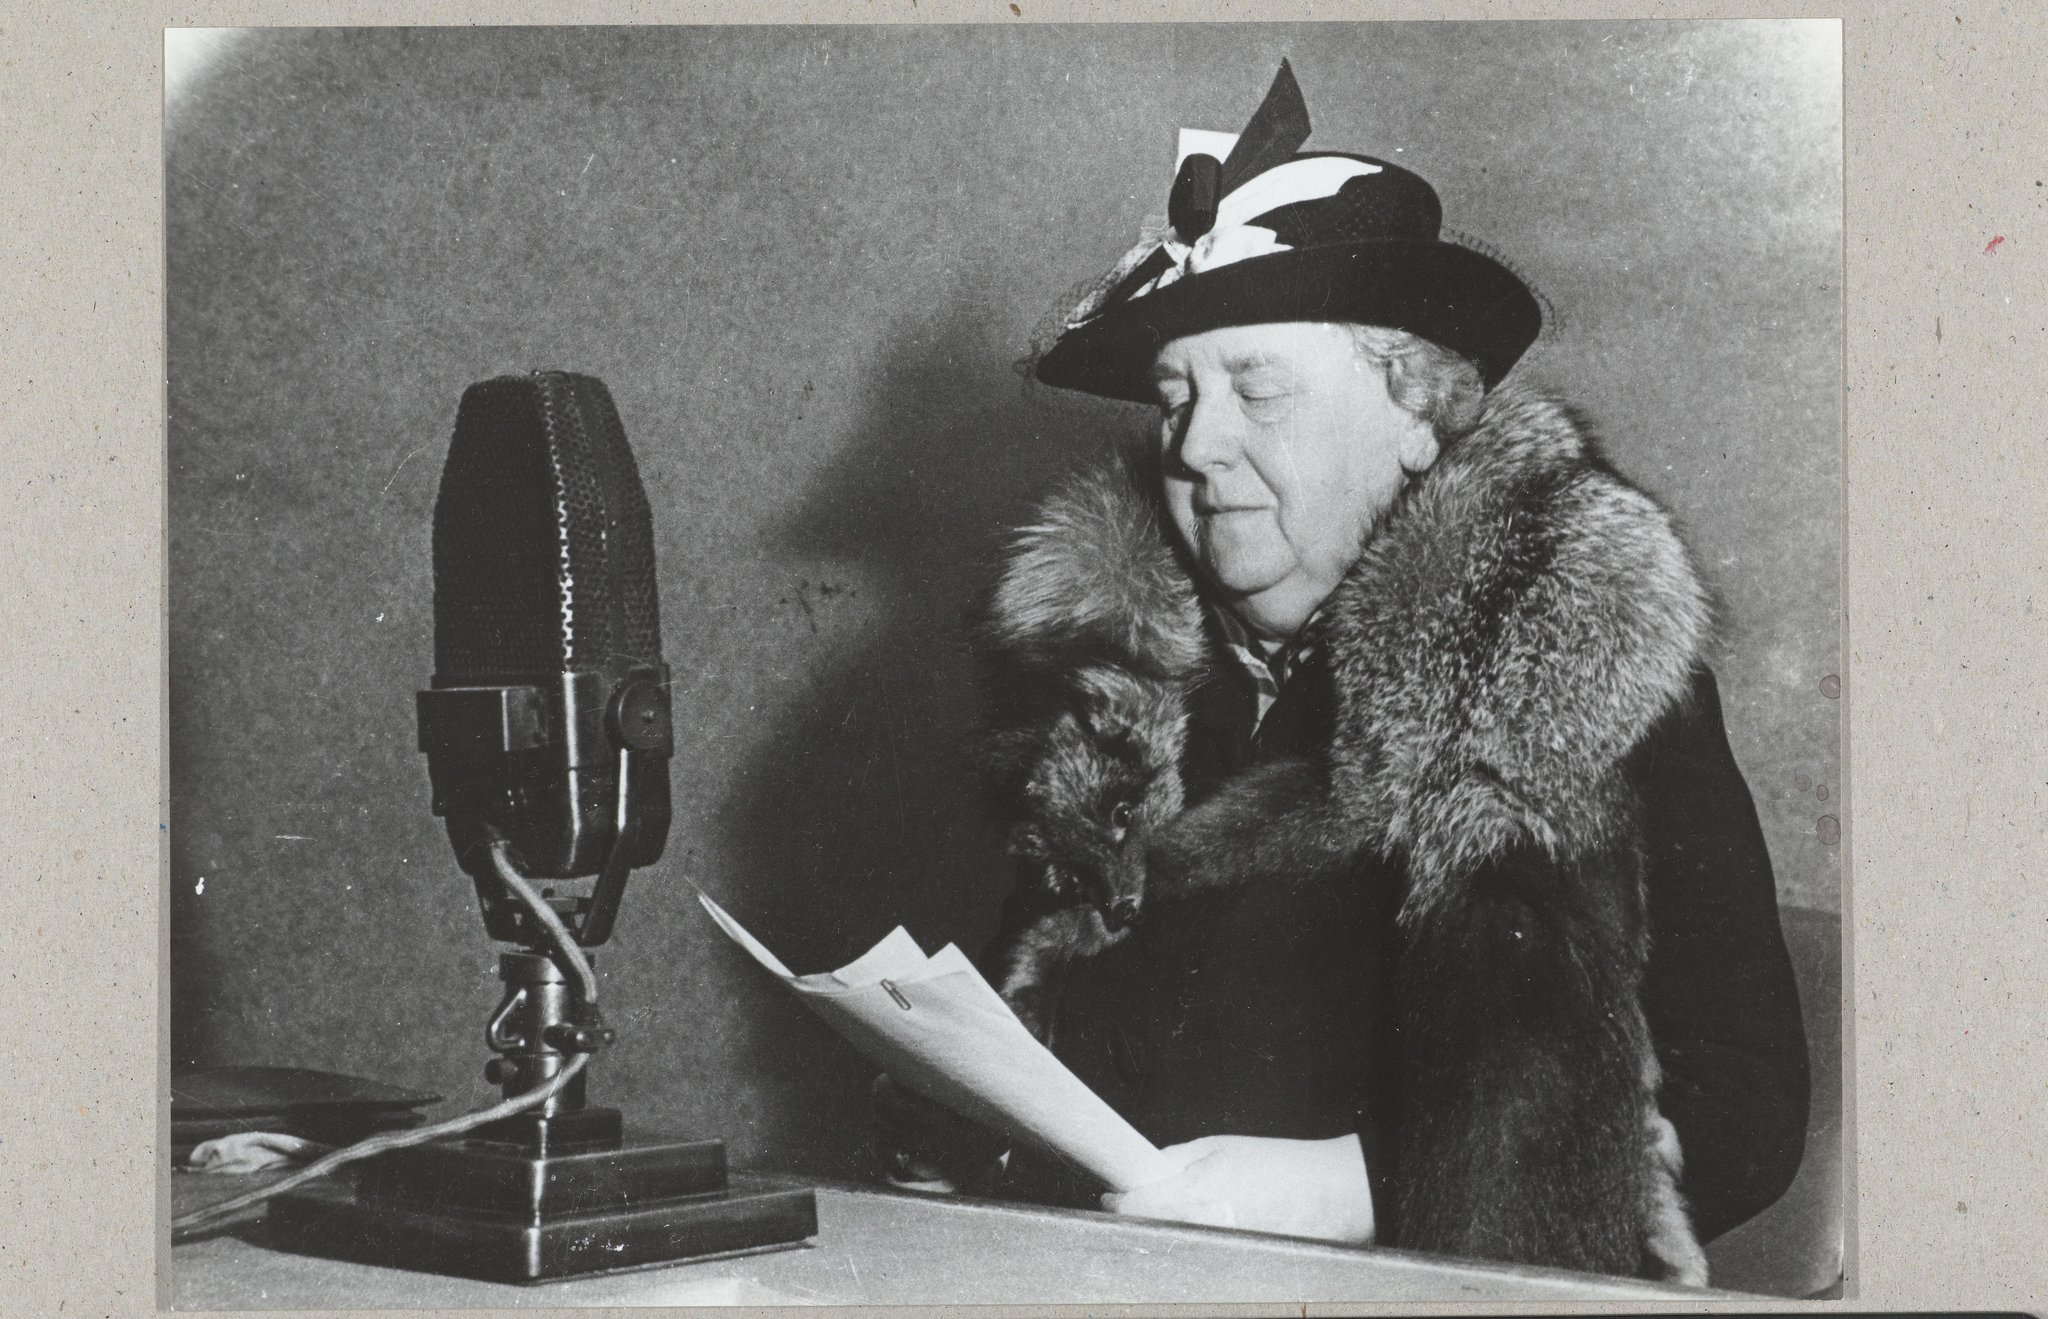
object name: photograph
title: Koningin Wilhelmina tijdens een toespraak voor Radio Oranje tijdens de Tweede Wereldoorlog, Londen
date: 1940-1945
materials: paper, photographic support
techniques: gelatin silver print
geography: netherlands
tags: the hague, print maker, wilhelmina of the netherlands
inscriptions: annotation: ‘Koningin Wilhelmina tijdens oorlog / voor radio Oranje Londen’, signature: ‘COPYRIGHT / "ANEFO" / KERKSTRAAT 310 / AMSTERDAM-C. / TEL. 30744 33902 / No. [in potlood ingevuld: PRF17-9733]’